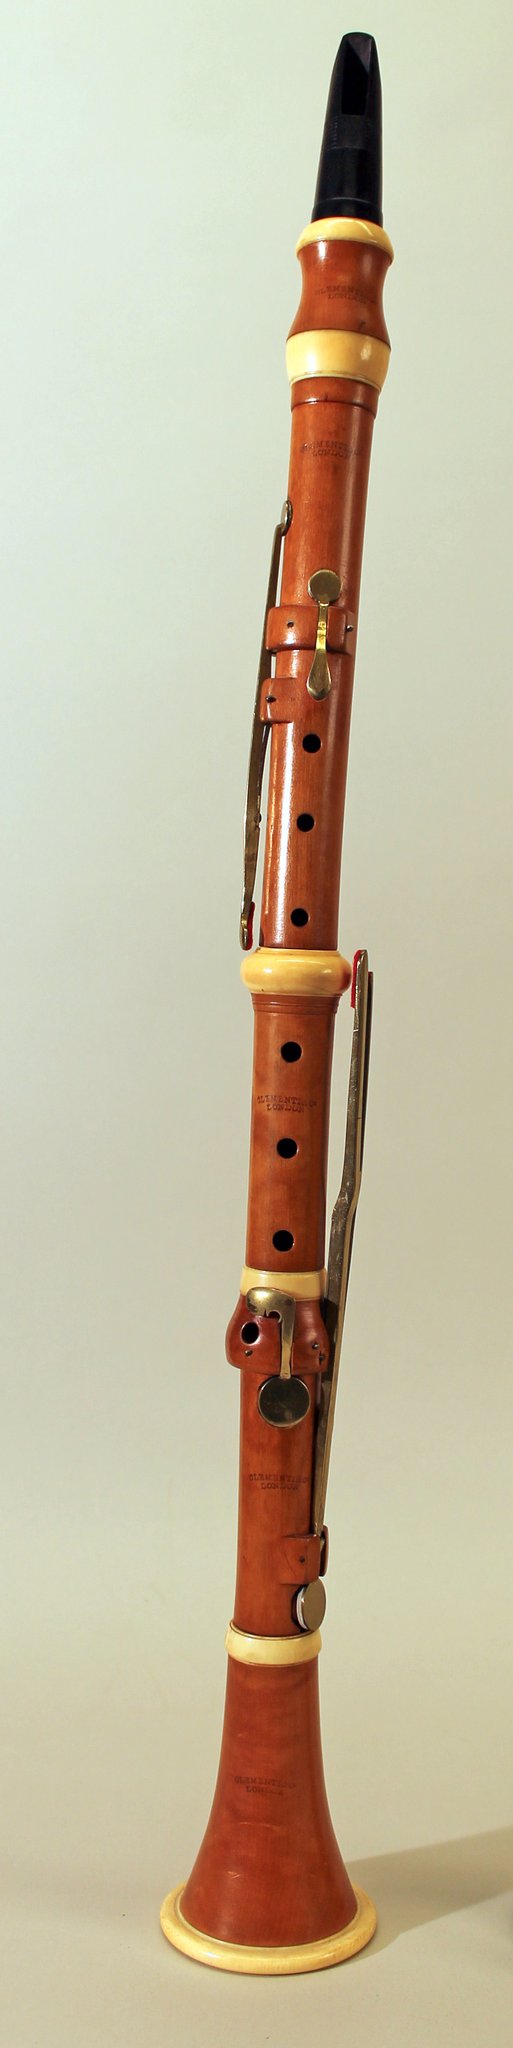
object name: clarinet in b flat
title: Clarinet in B-flat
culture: british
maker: clementi & co.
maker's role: maker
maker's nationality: british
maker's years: 1798-1828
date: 1805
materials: wood, brass, ivory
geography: united kingdom